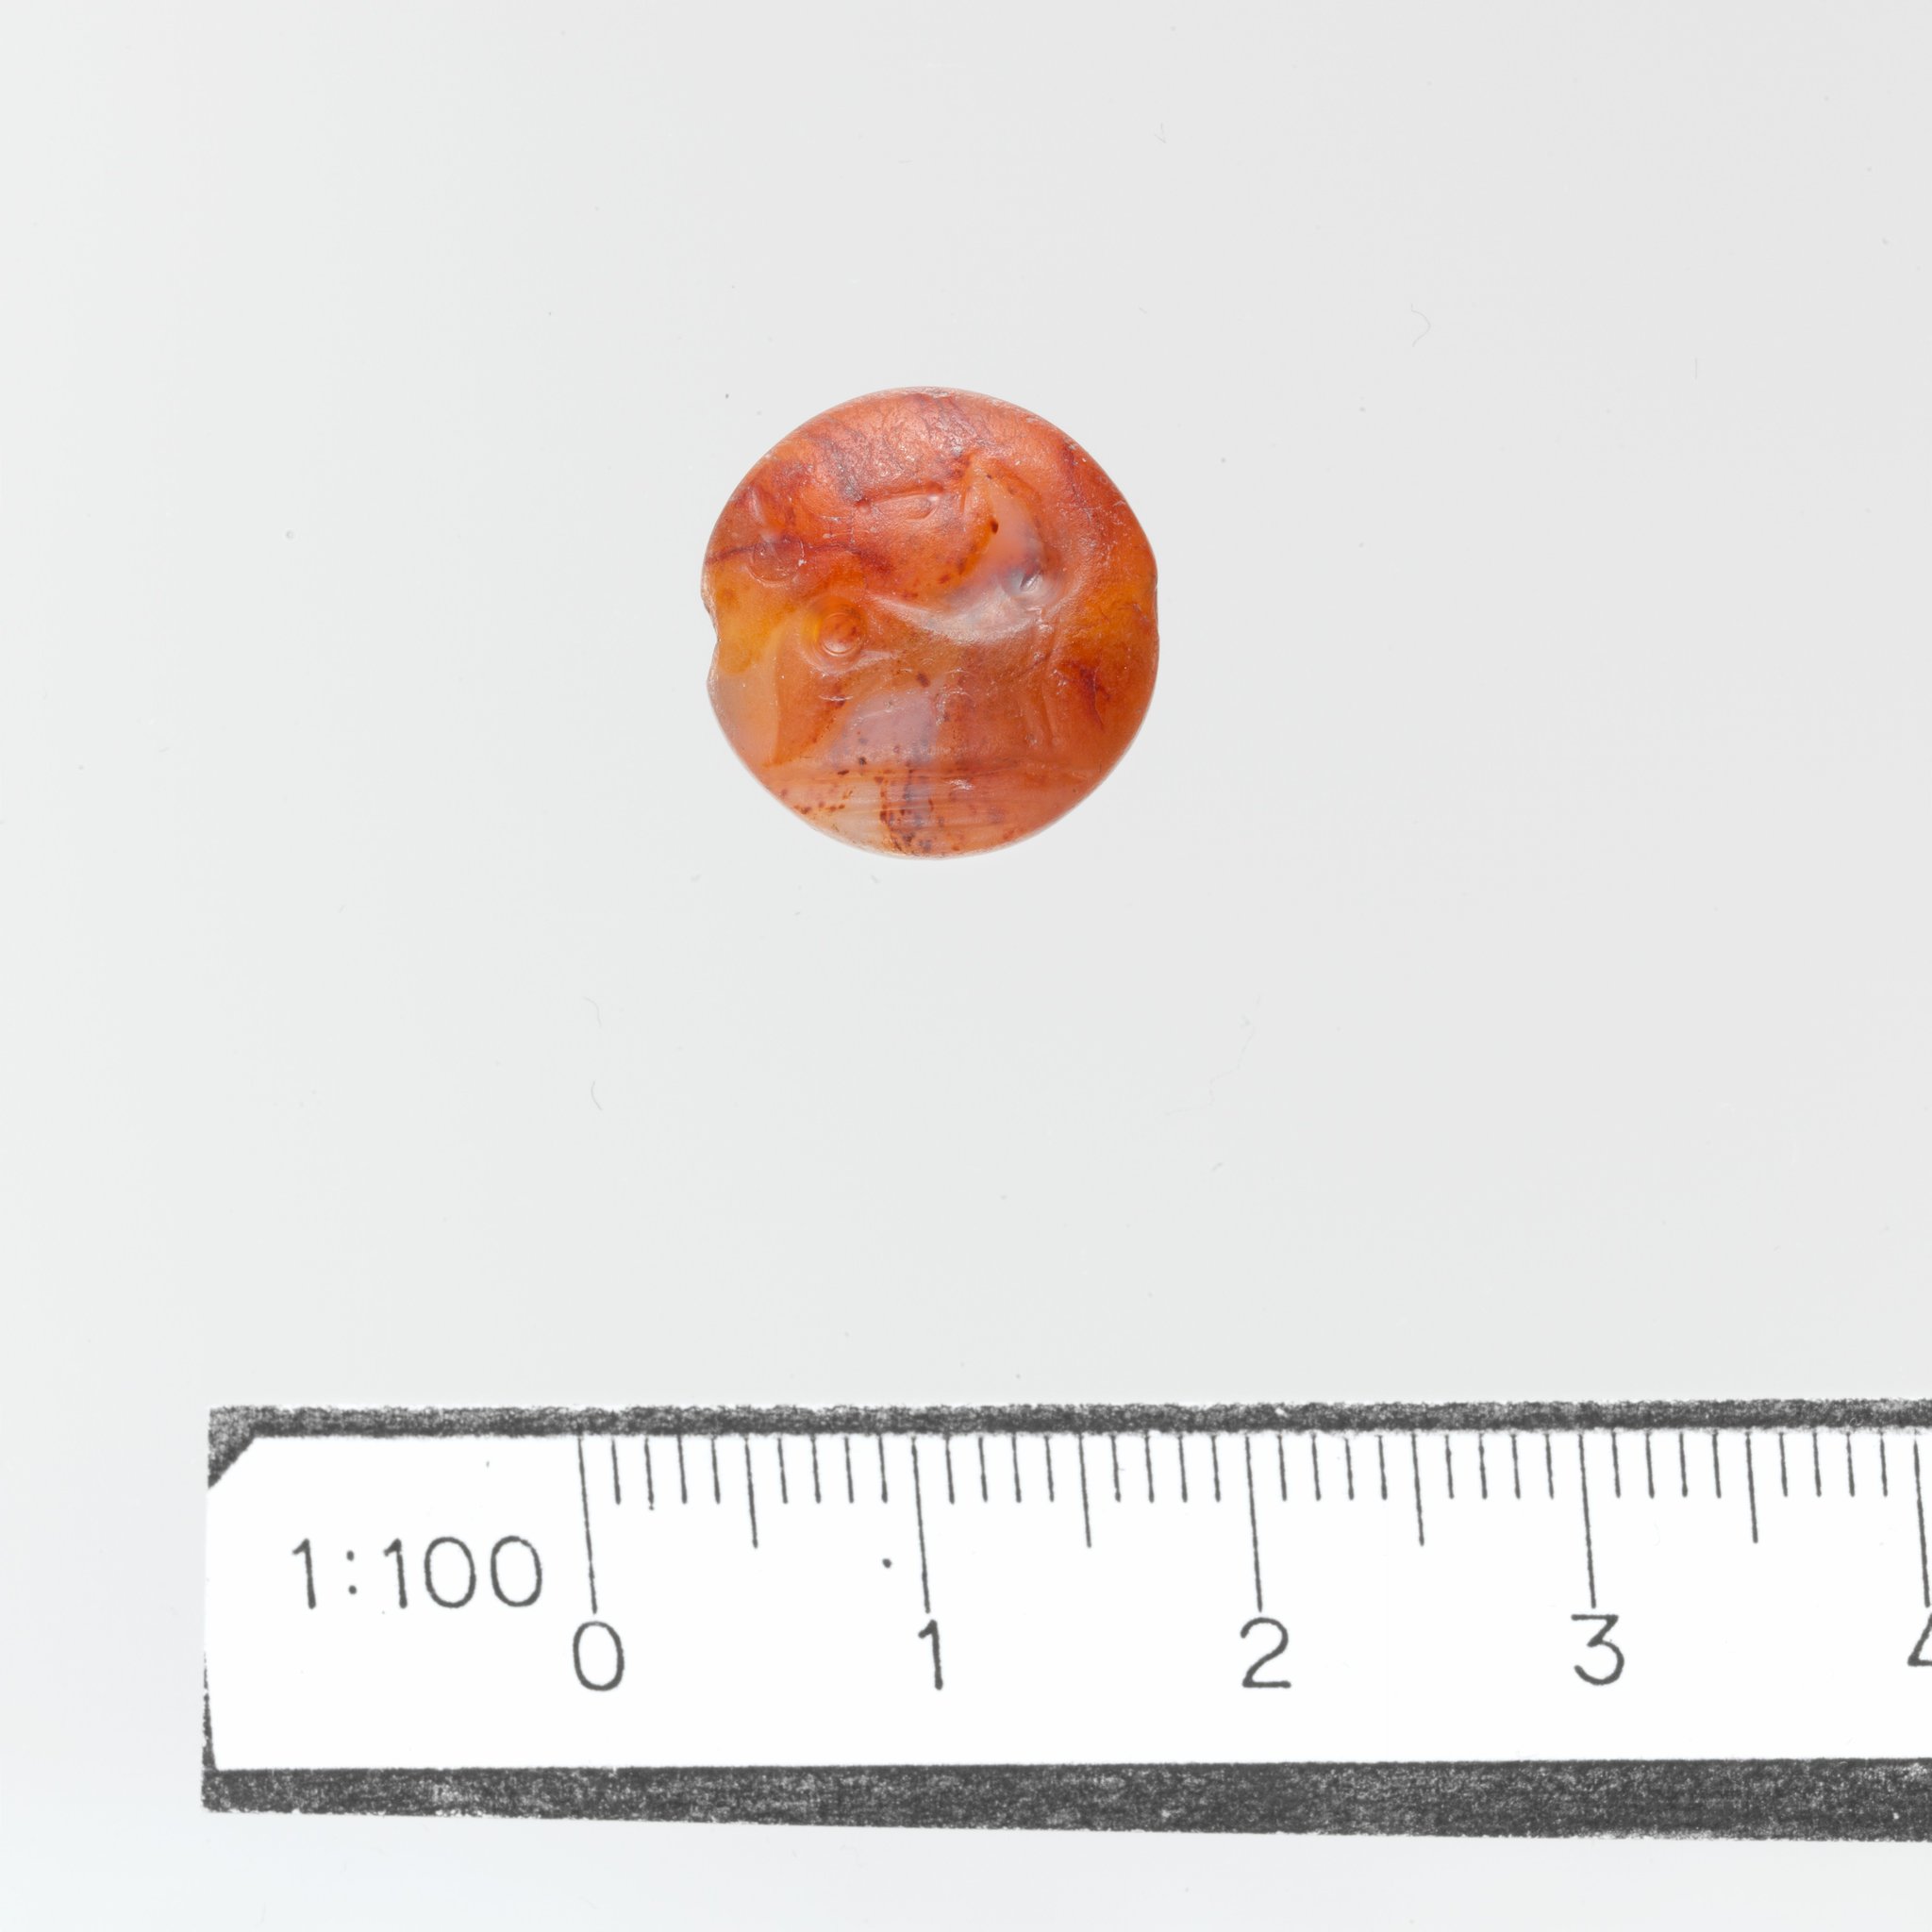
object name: seal, lentoid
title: Chalcedony lentoid seal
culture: minoan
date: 1700-1450 BCE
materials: gemstone